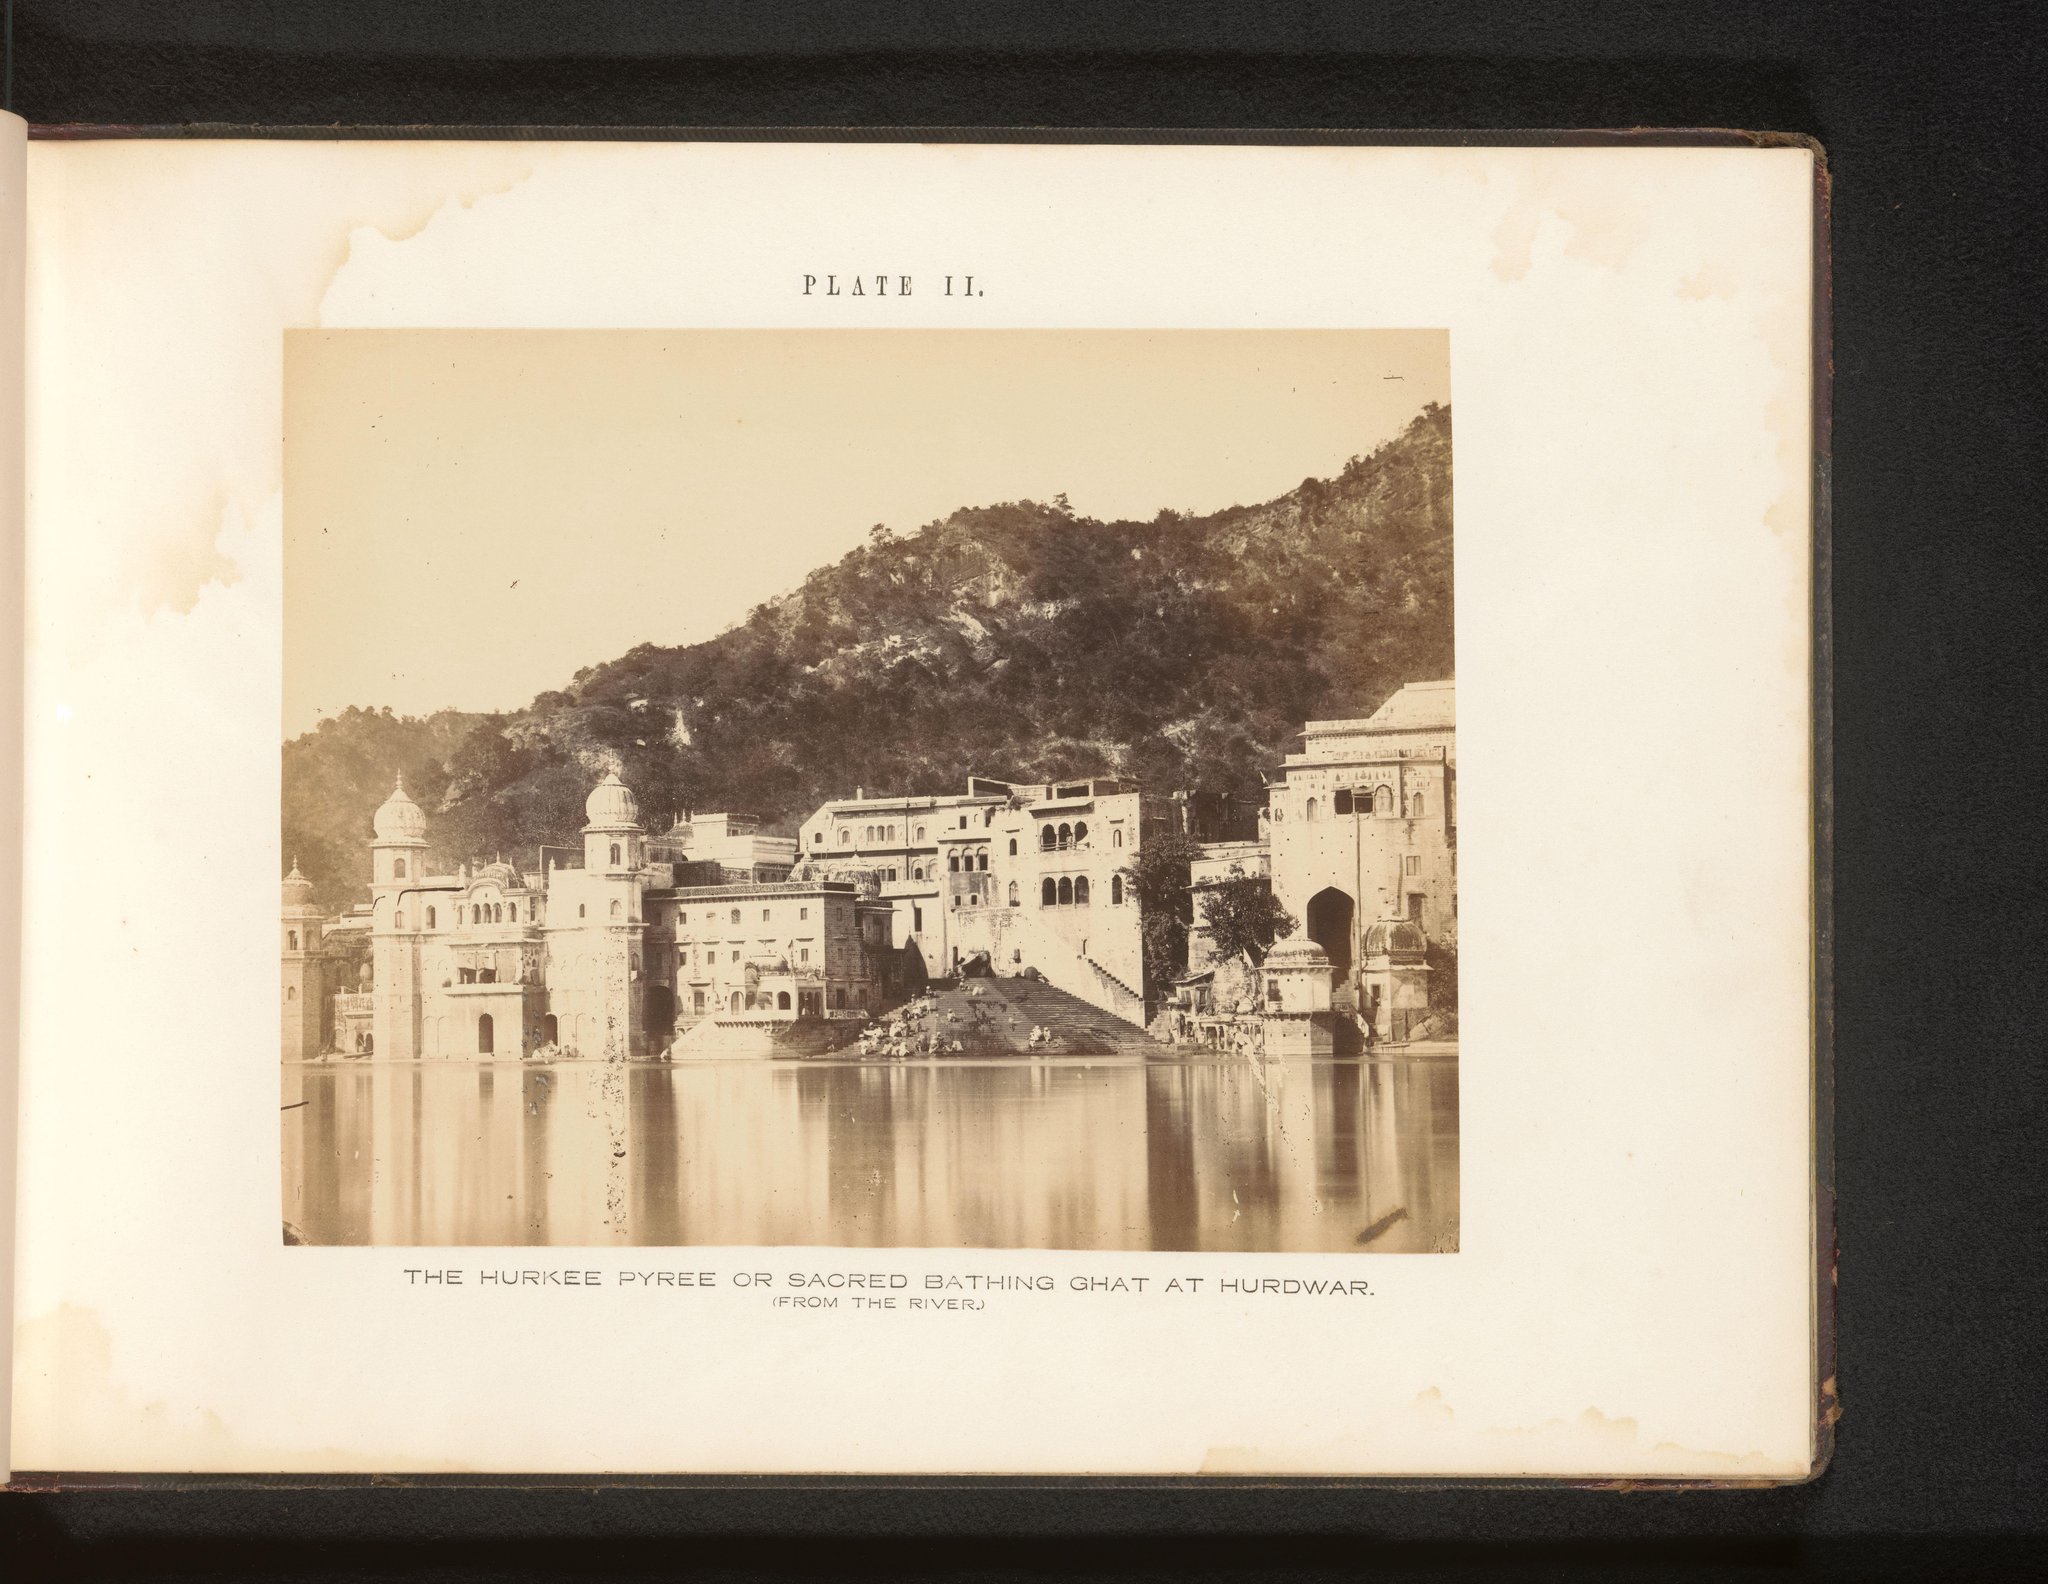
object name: page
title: The Hurkee Pyree or sacred bathing ghat at Hurdwar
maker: thomas george glover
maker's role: fotograaf, luitenant-kolonel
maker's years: 1825-1881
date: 1862-1867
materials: photographic support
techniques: albumen print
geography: haridwar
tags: flight of steps, river bank, civic architecture; edifices; dwellings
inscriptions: inscription: ‘Plate II’